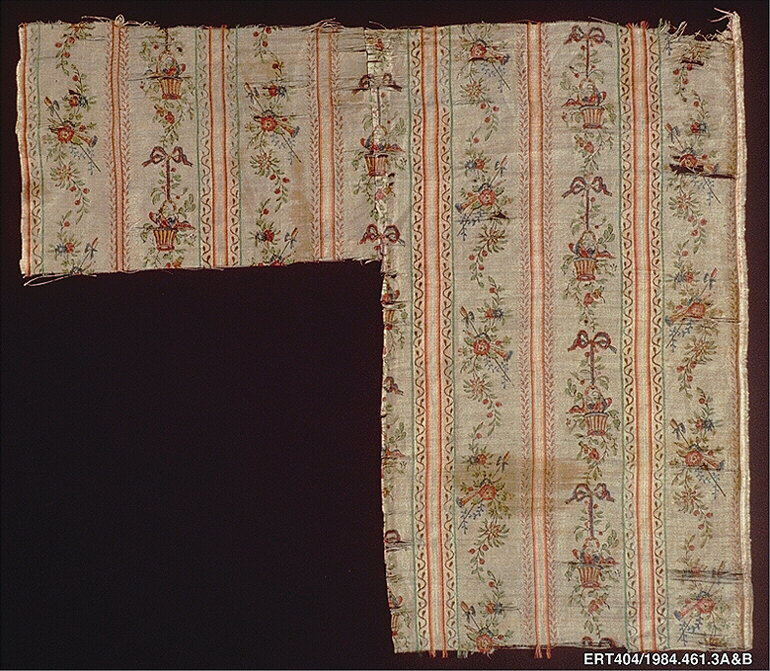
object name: piece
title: Piece (one of two)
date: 1801-1900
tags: flowers